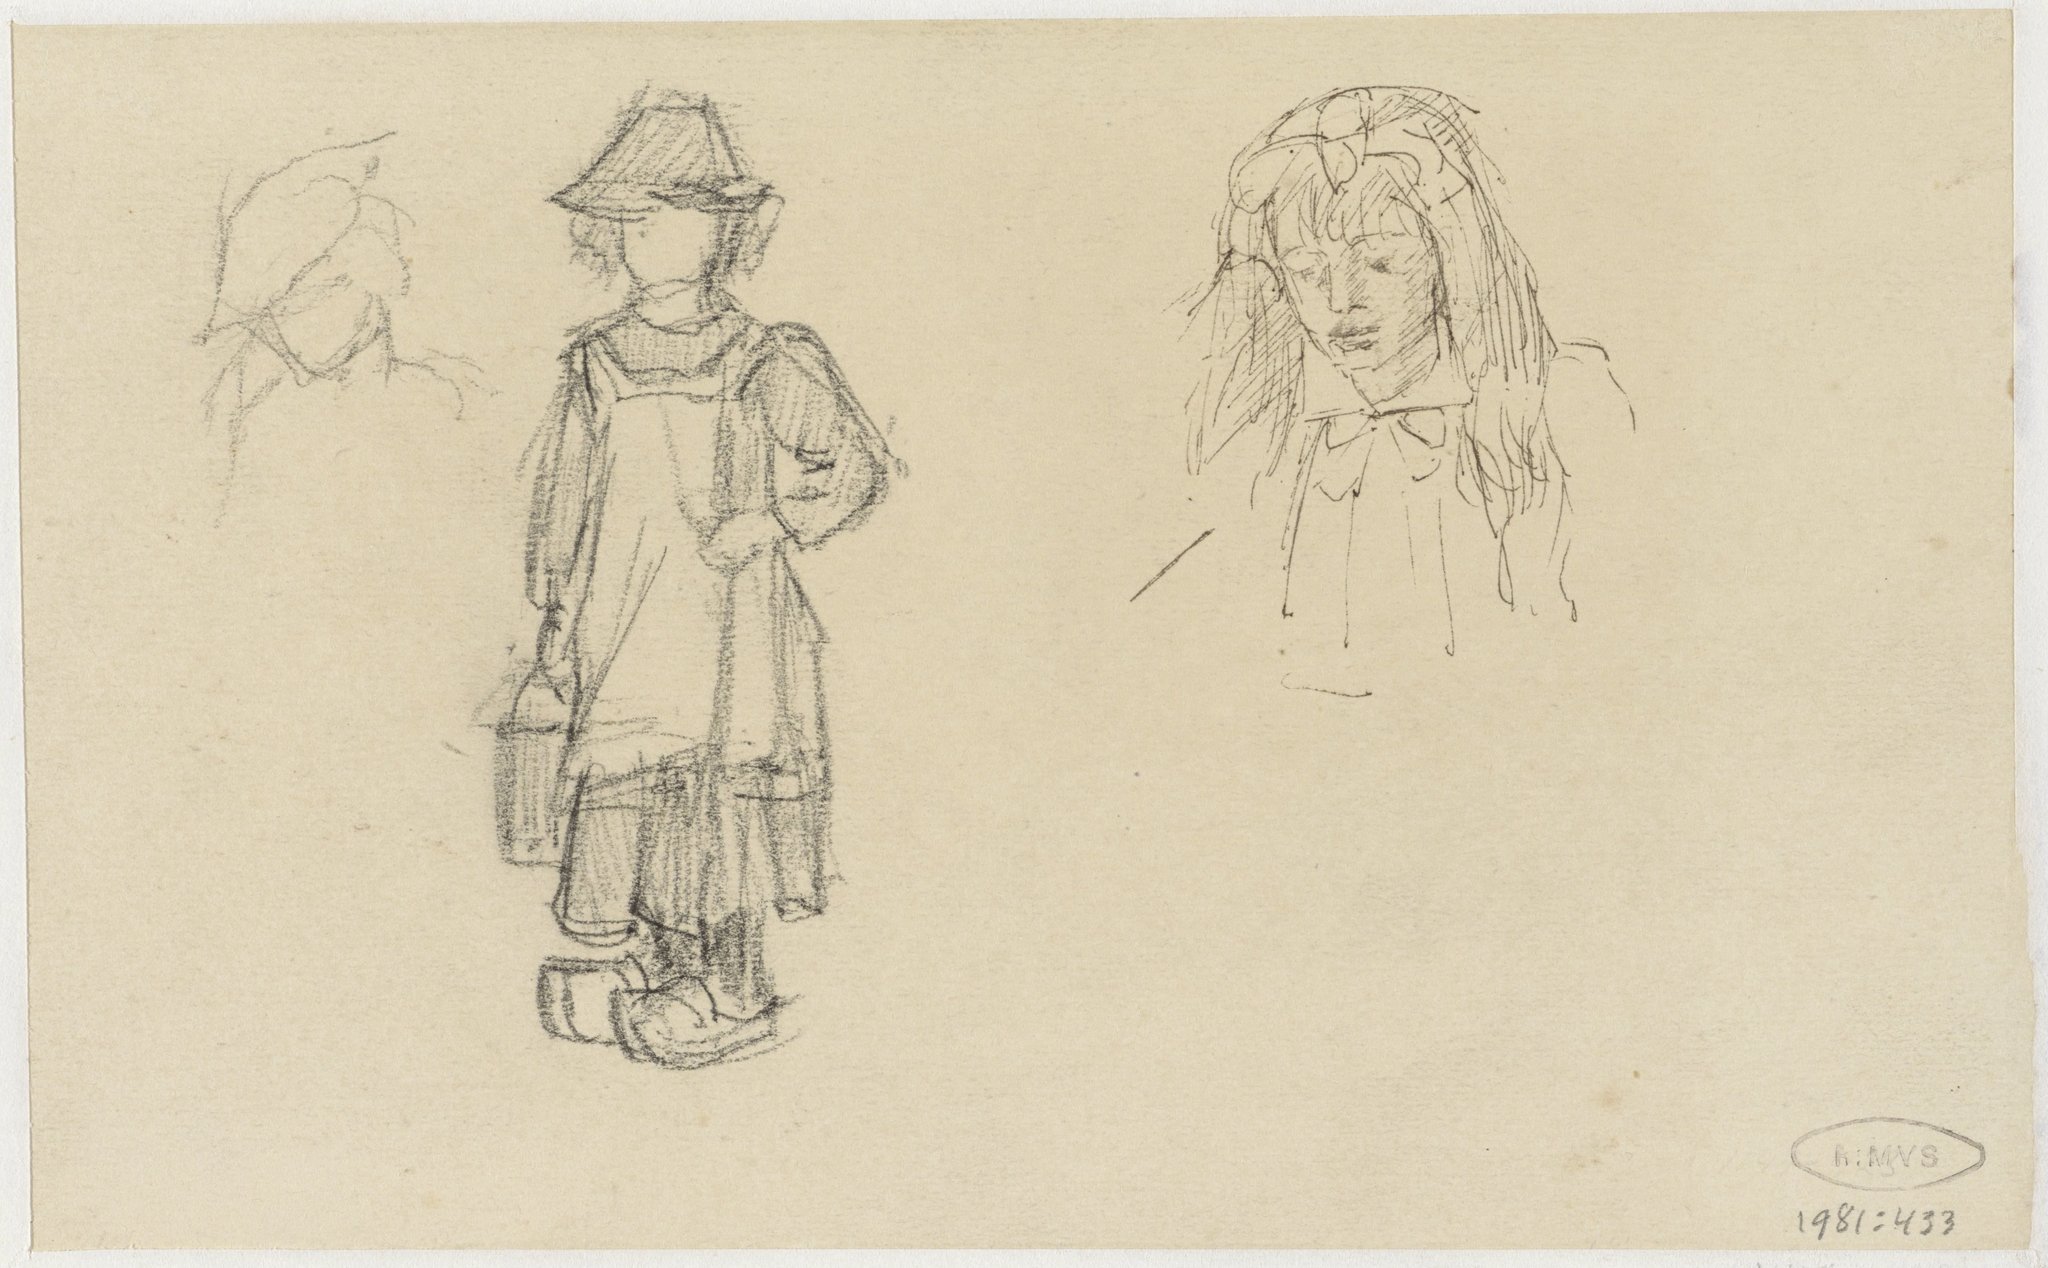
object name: drawing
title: Schetsen van een meisje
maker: jozef israëls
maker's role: draughtsman, painter, print maker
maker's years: 1824-1911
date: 1834-1911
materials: chalk, ink, paper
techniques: pen